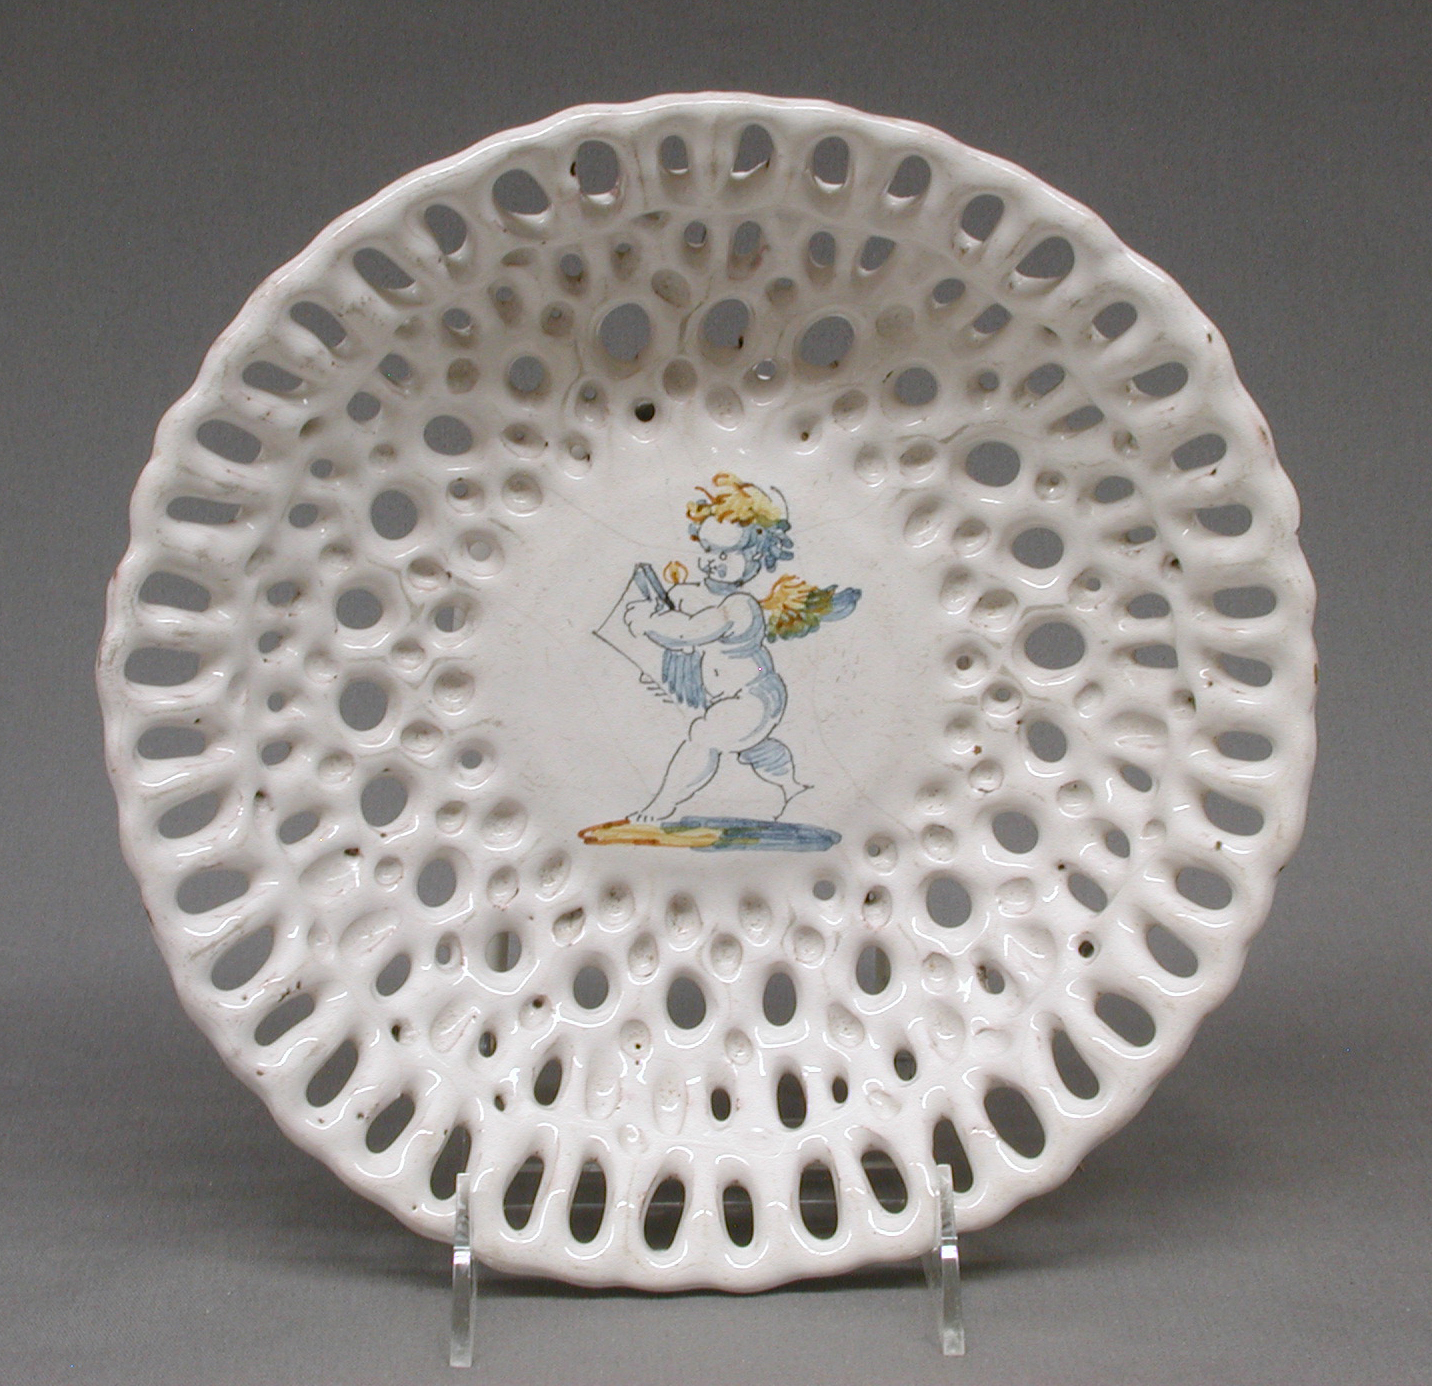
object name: footed dish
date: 1551-1600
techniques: maiolica, glazing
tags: putti